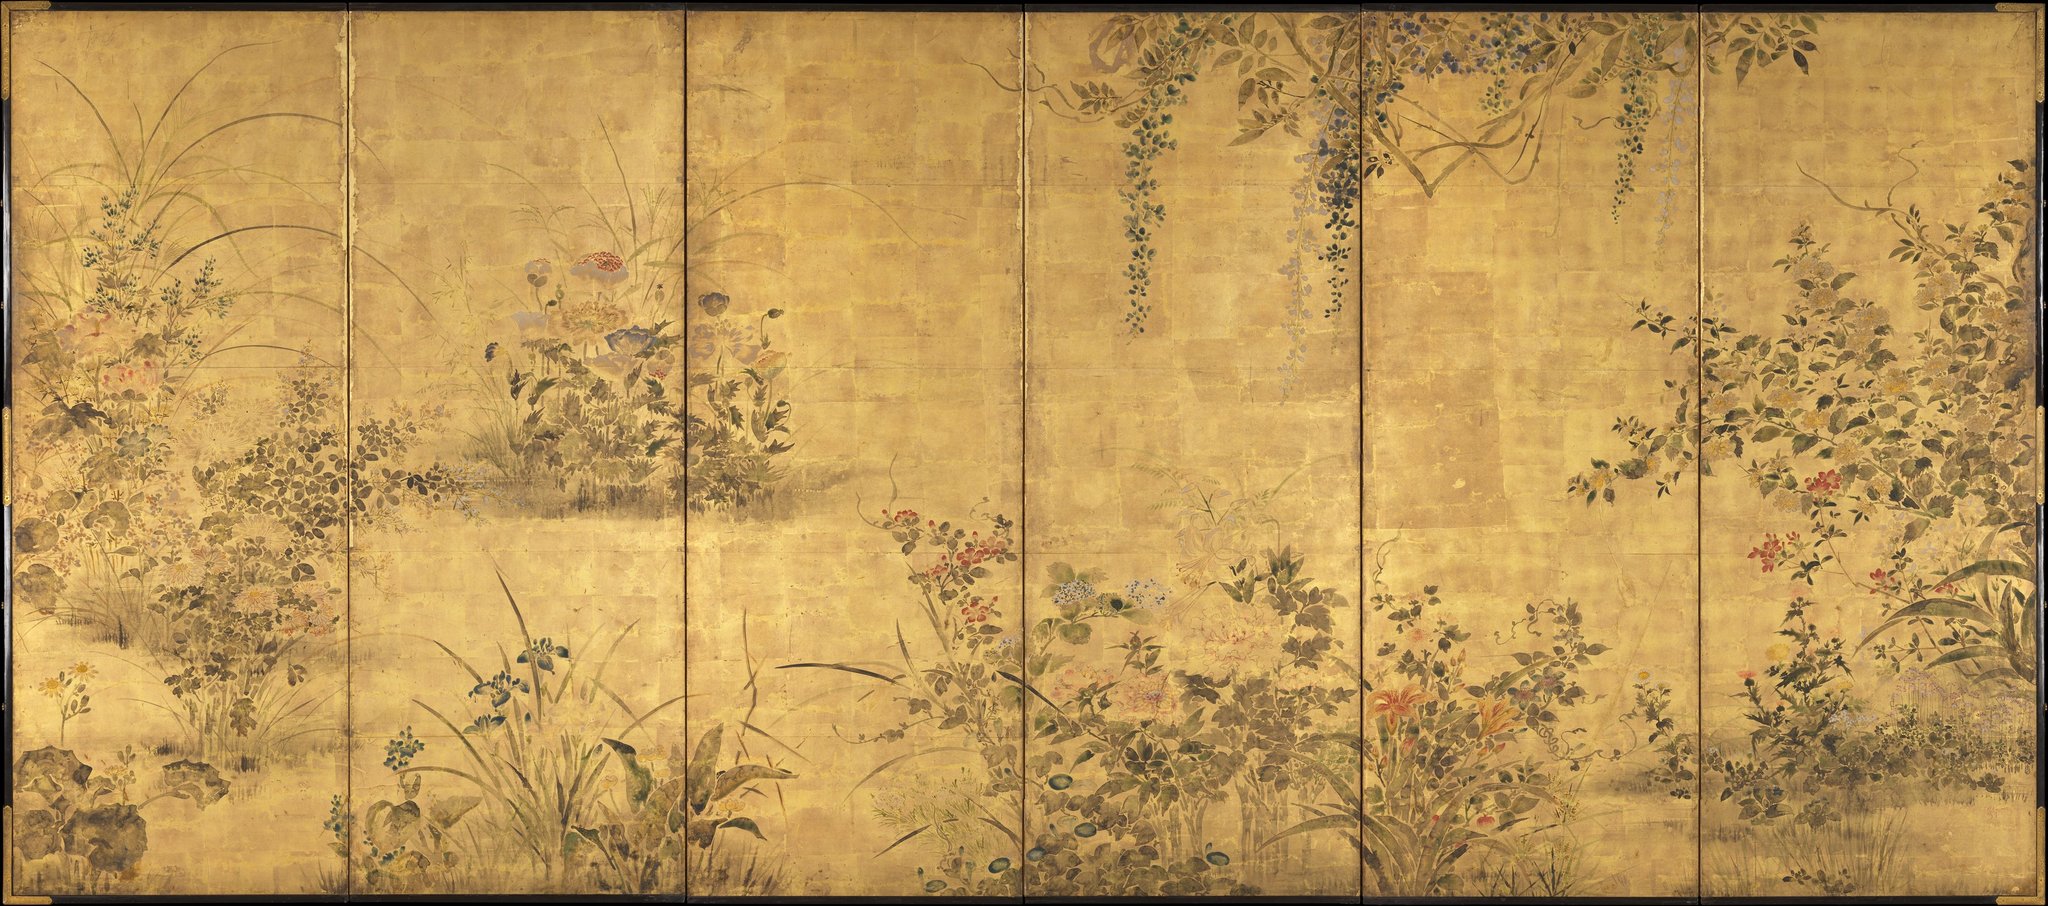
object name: screen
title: Flowering Plants and Vegetables of the Four Seasons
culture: japanese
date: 1701-1733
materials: gold leaf, ink, panel, paper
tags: flowers,plants